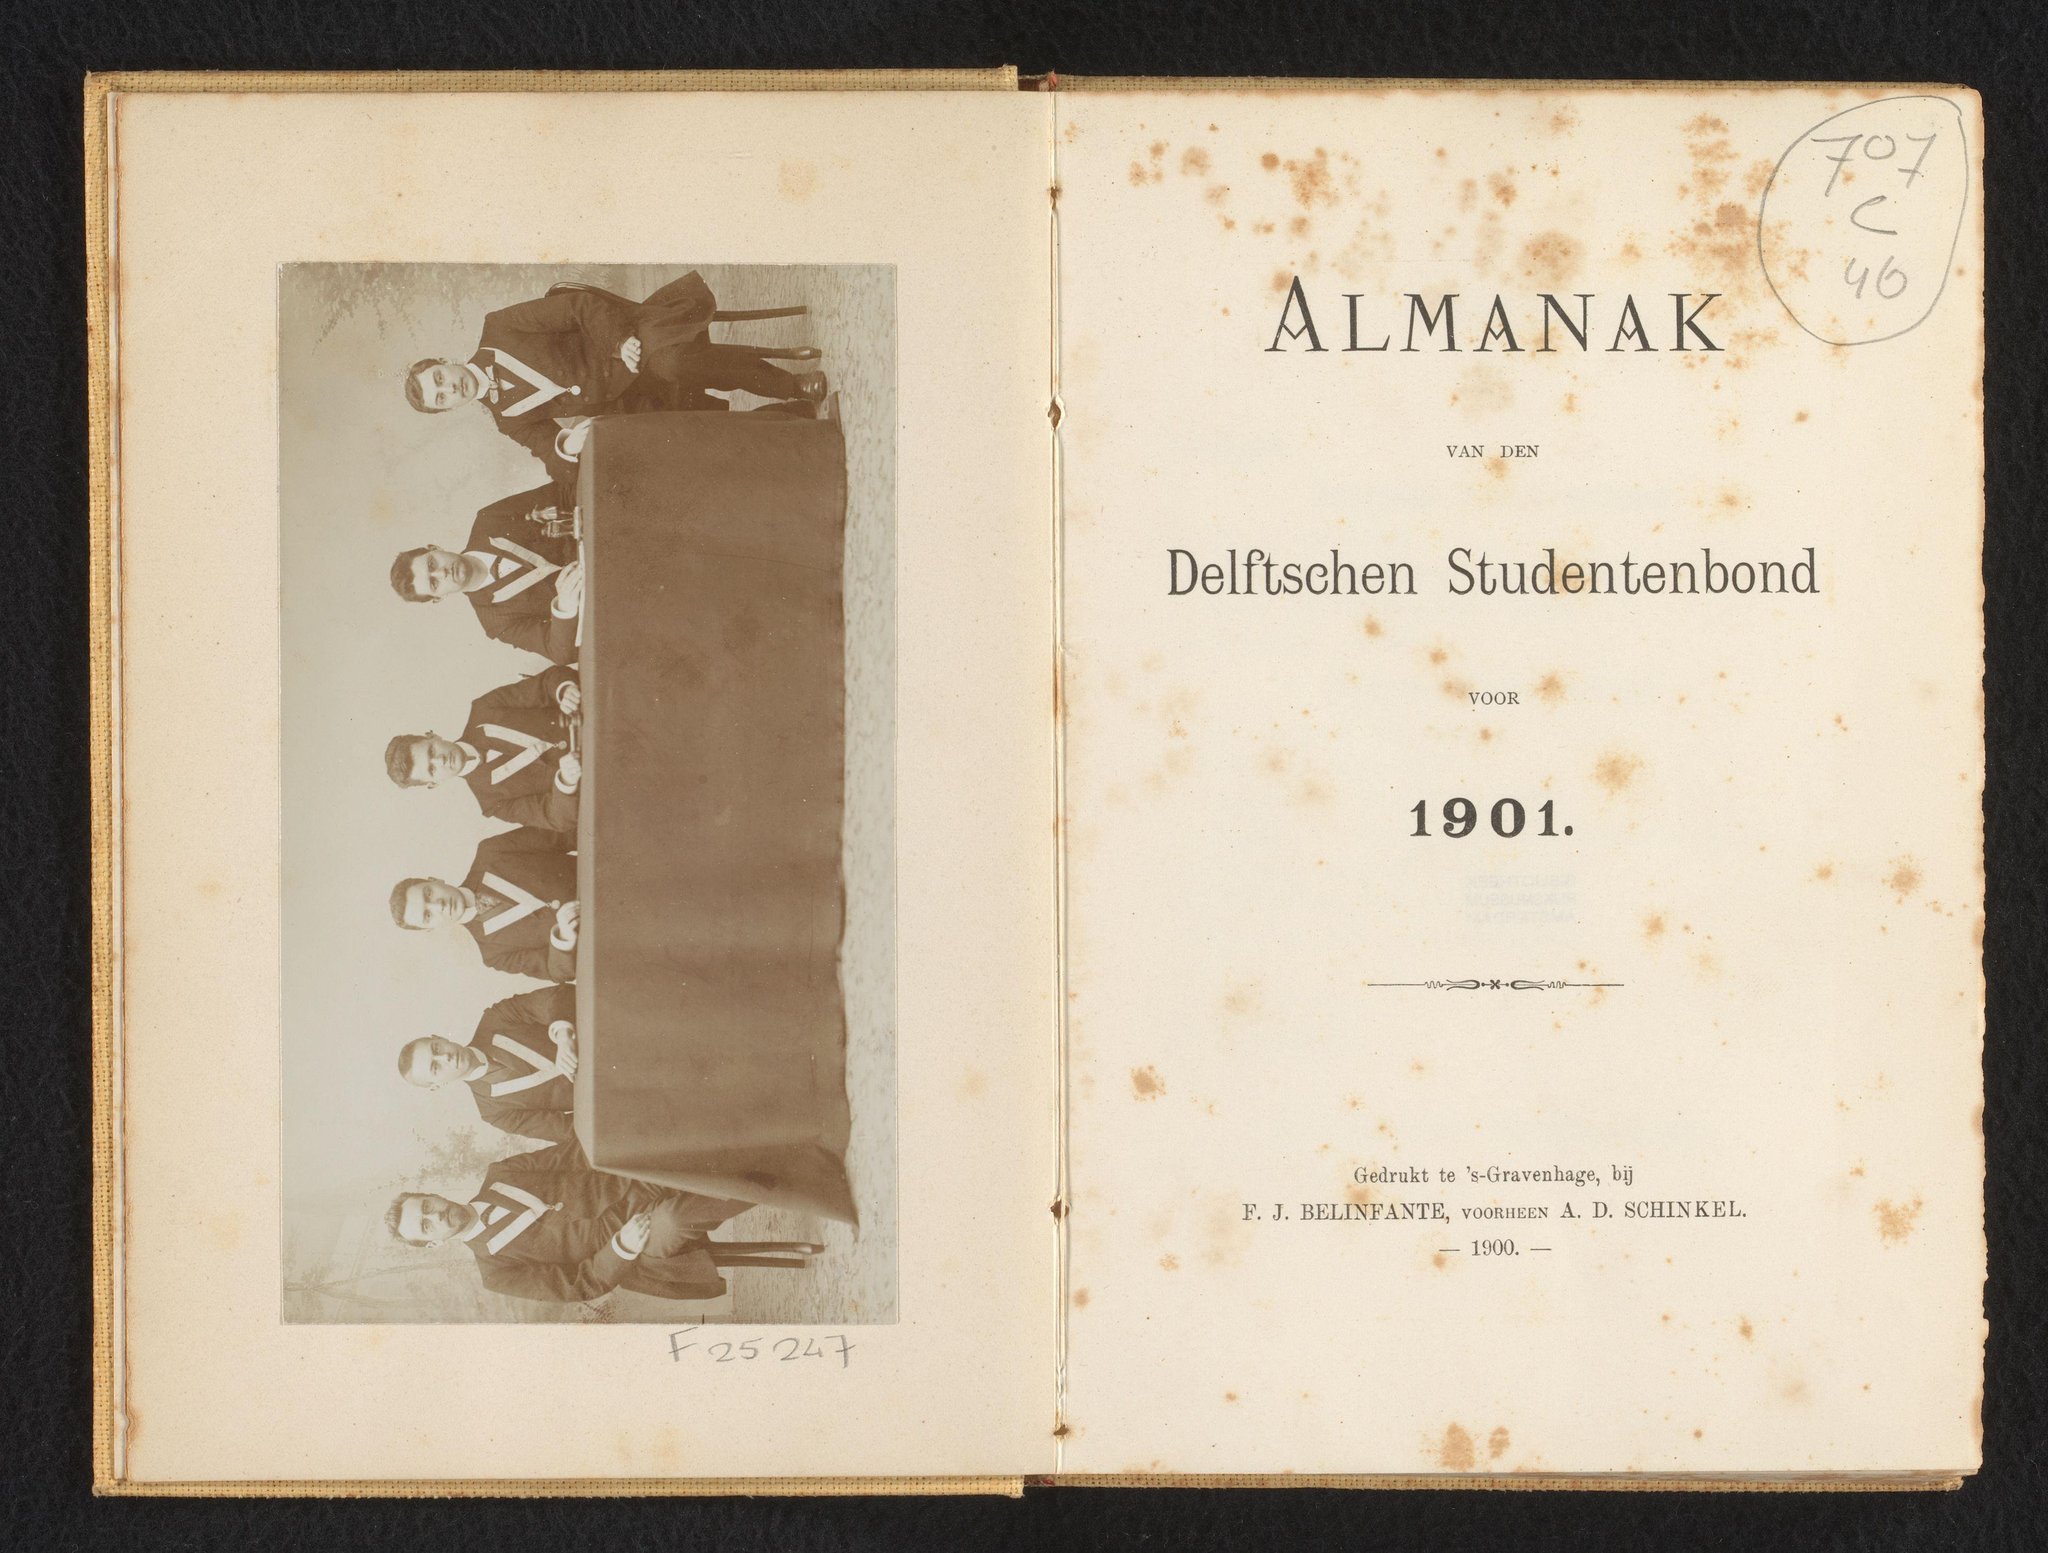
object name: photograph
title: Groepsportret van het bestuur van de Delftsche Studentenbond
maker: Anonymous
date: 1900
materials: paper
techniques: collodion silver print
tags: fraternity (students), historical persons, delft